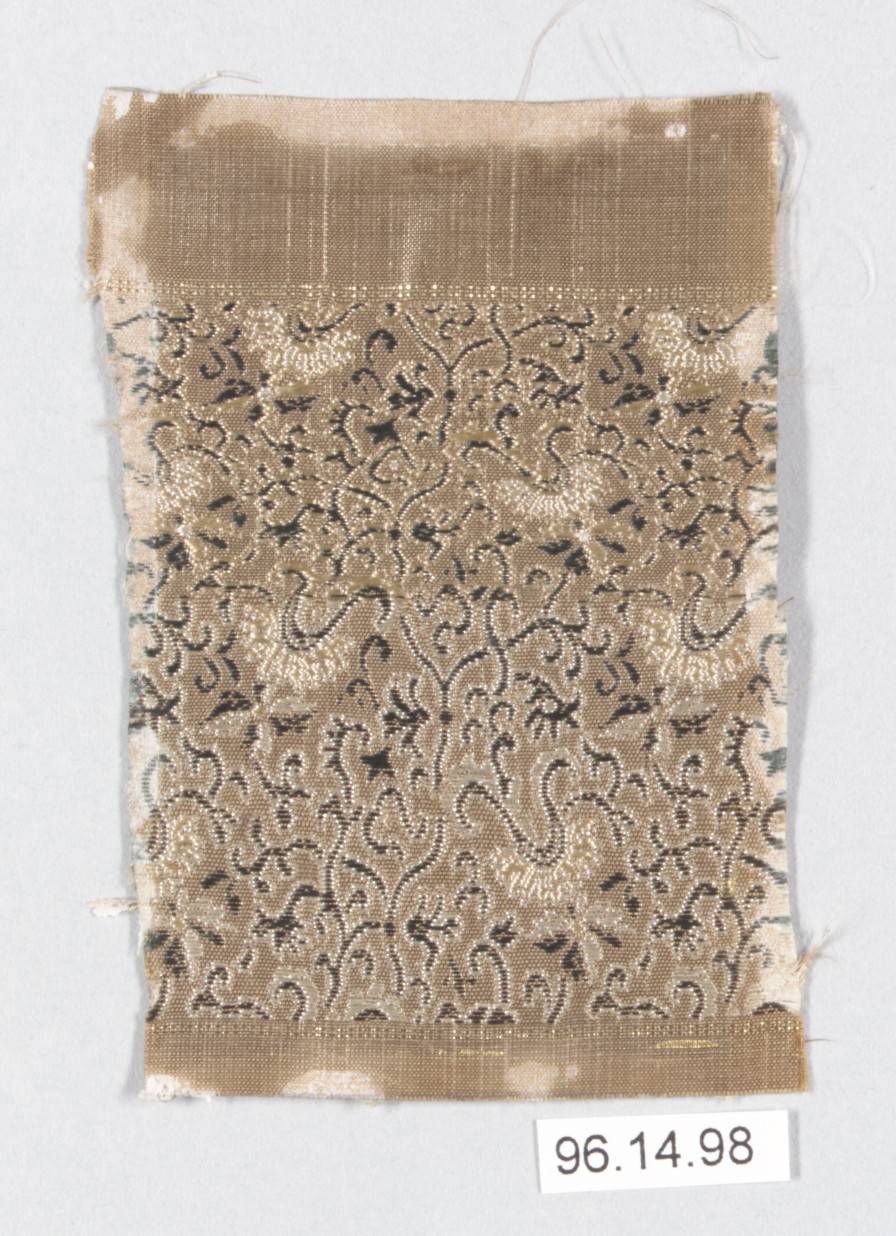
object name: piece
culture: japanese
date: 1701-1900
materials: silk